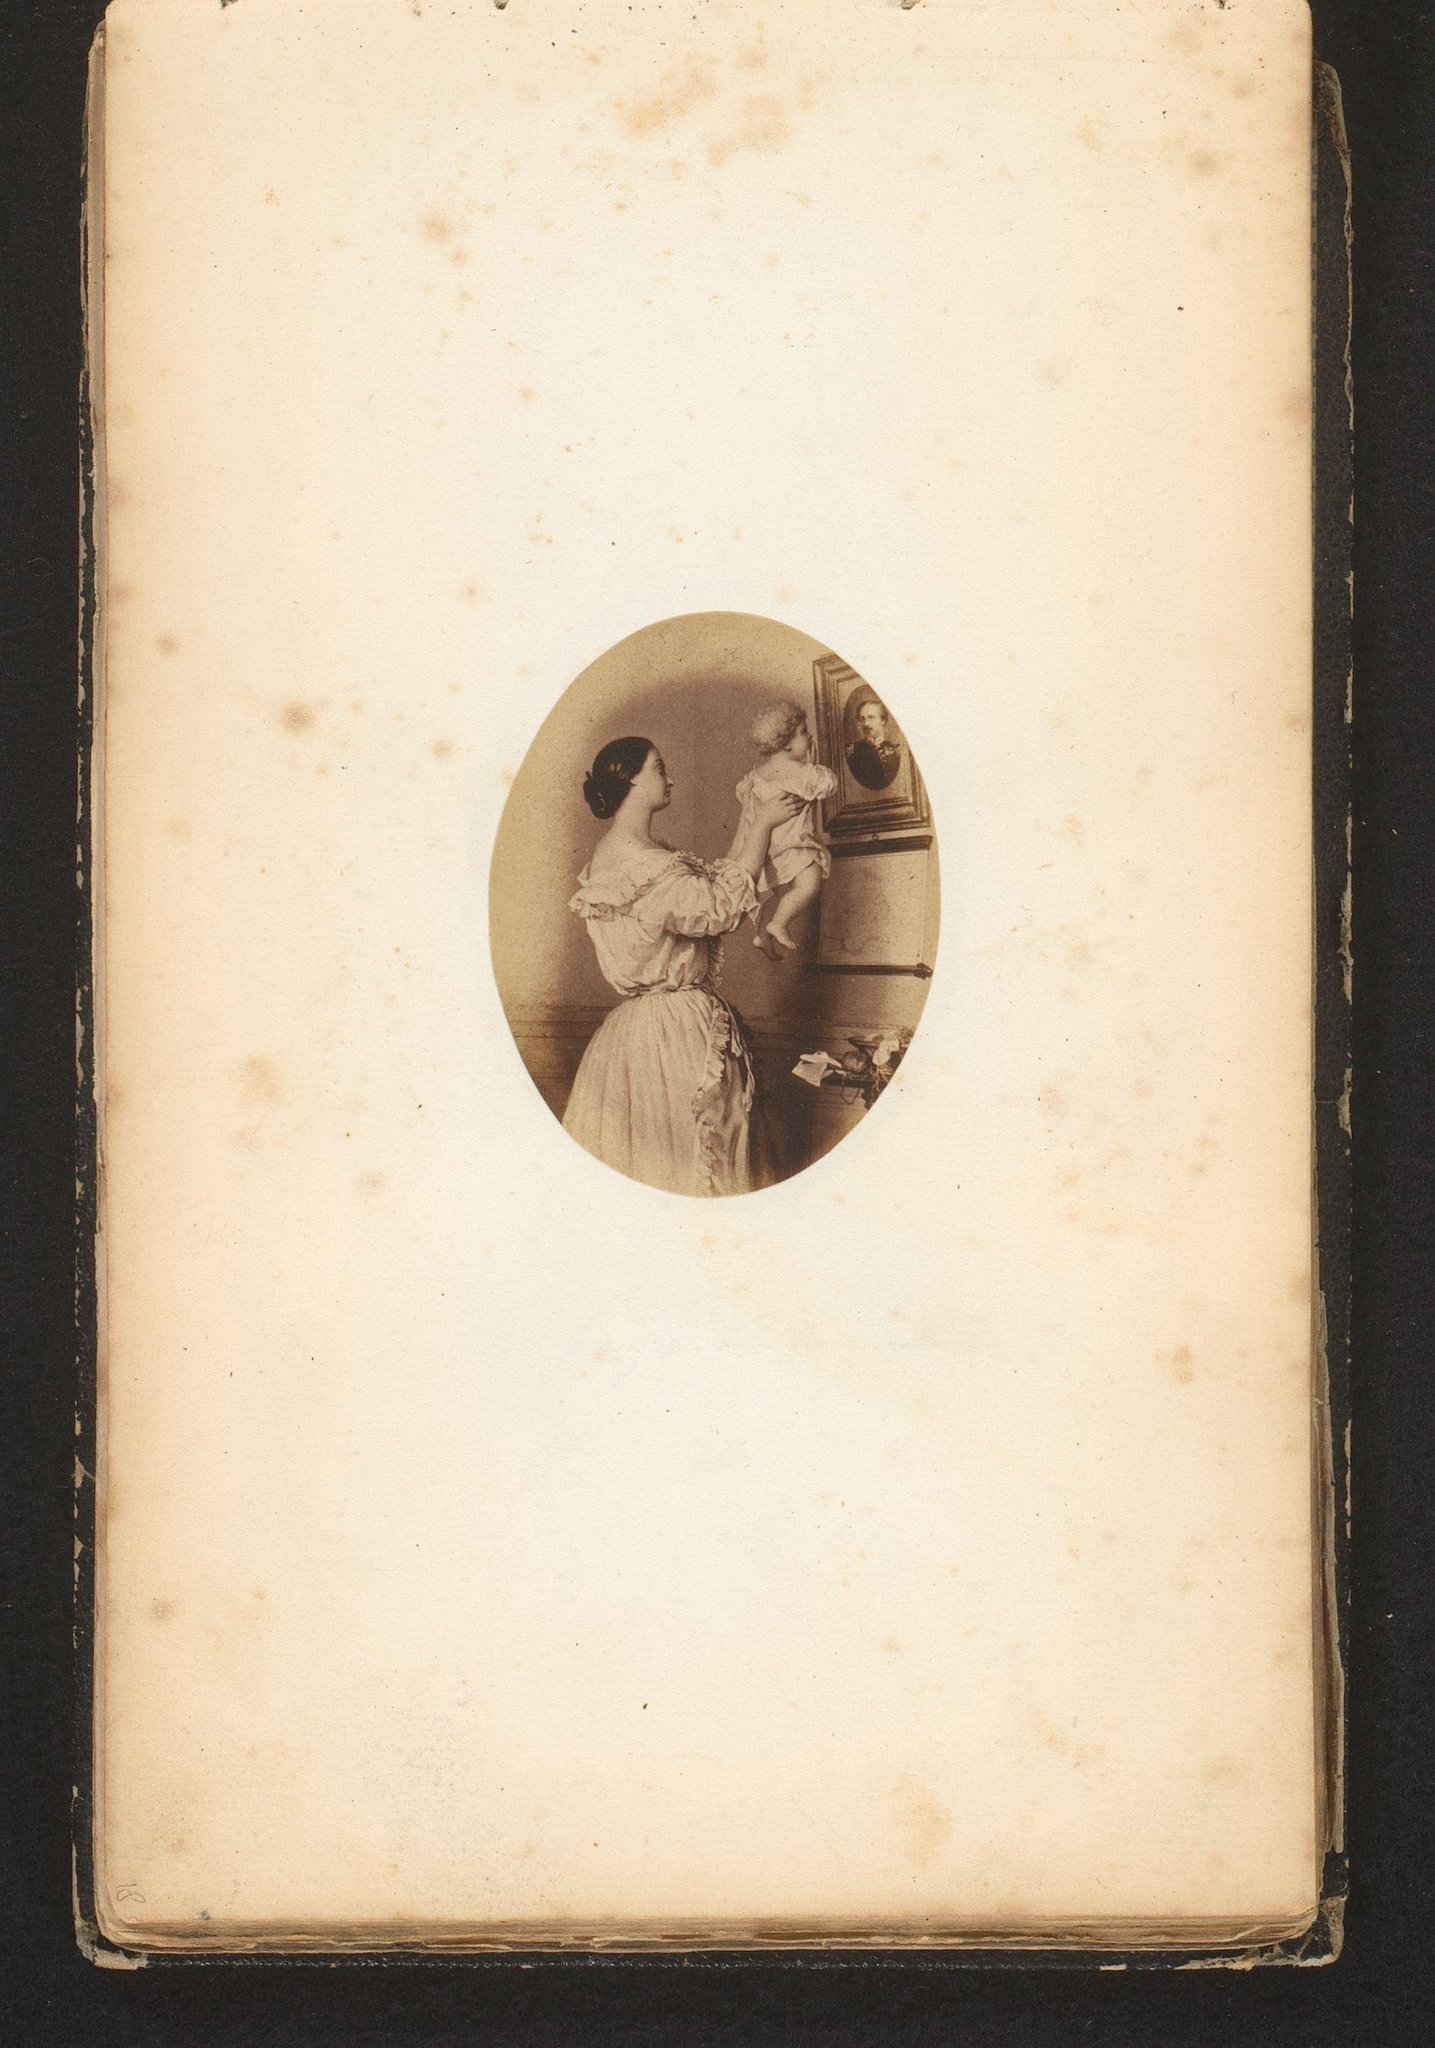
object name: album leaf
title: Fotoreproductie van een schilderij van een moeder die haar kind ophoudt om naar een geschilder portret van een man te kijken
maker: Anonymous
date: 1860-1900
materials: photographic support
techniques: albumen print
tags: standing figure, mother and baby or young child, painting, drawing and the graphic arts